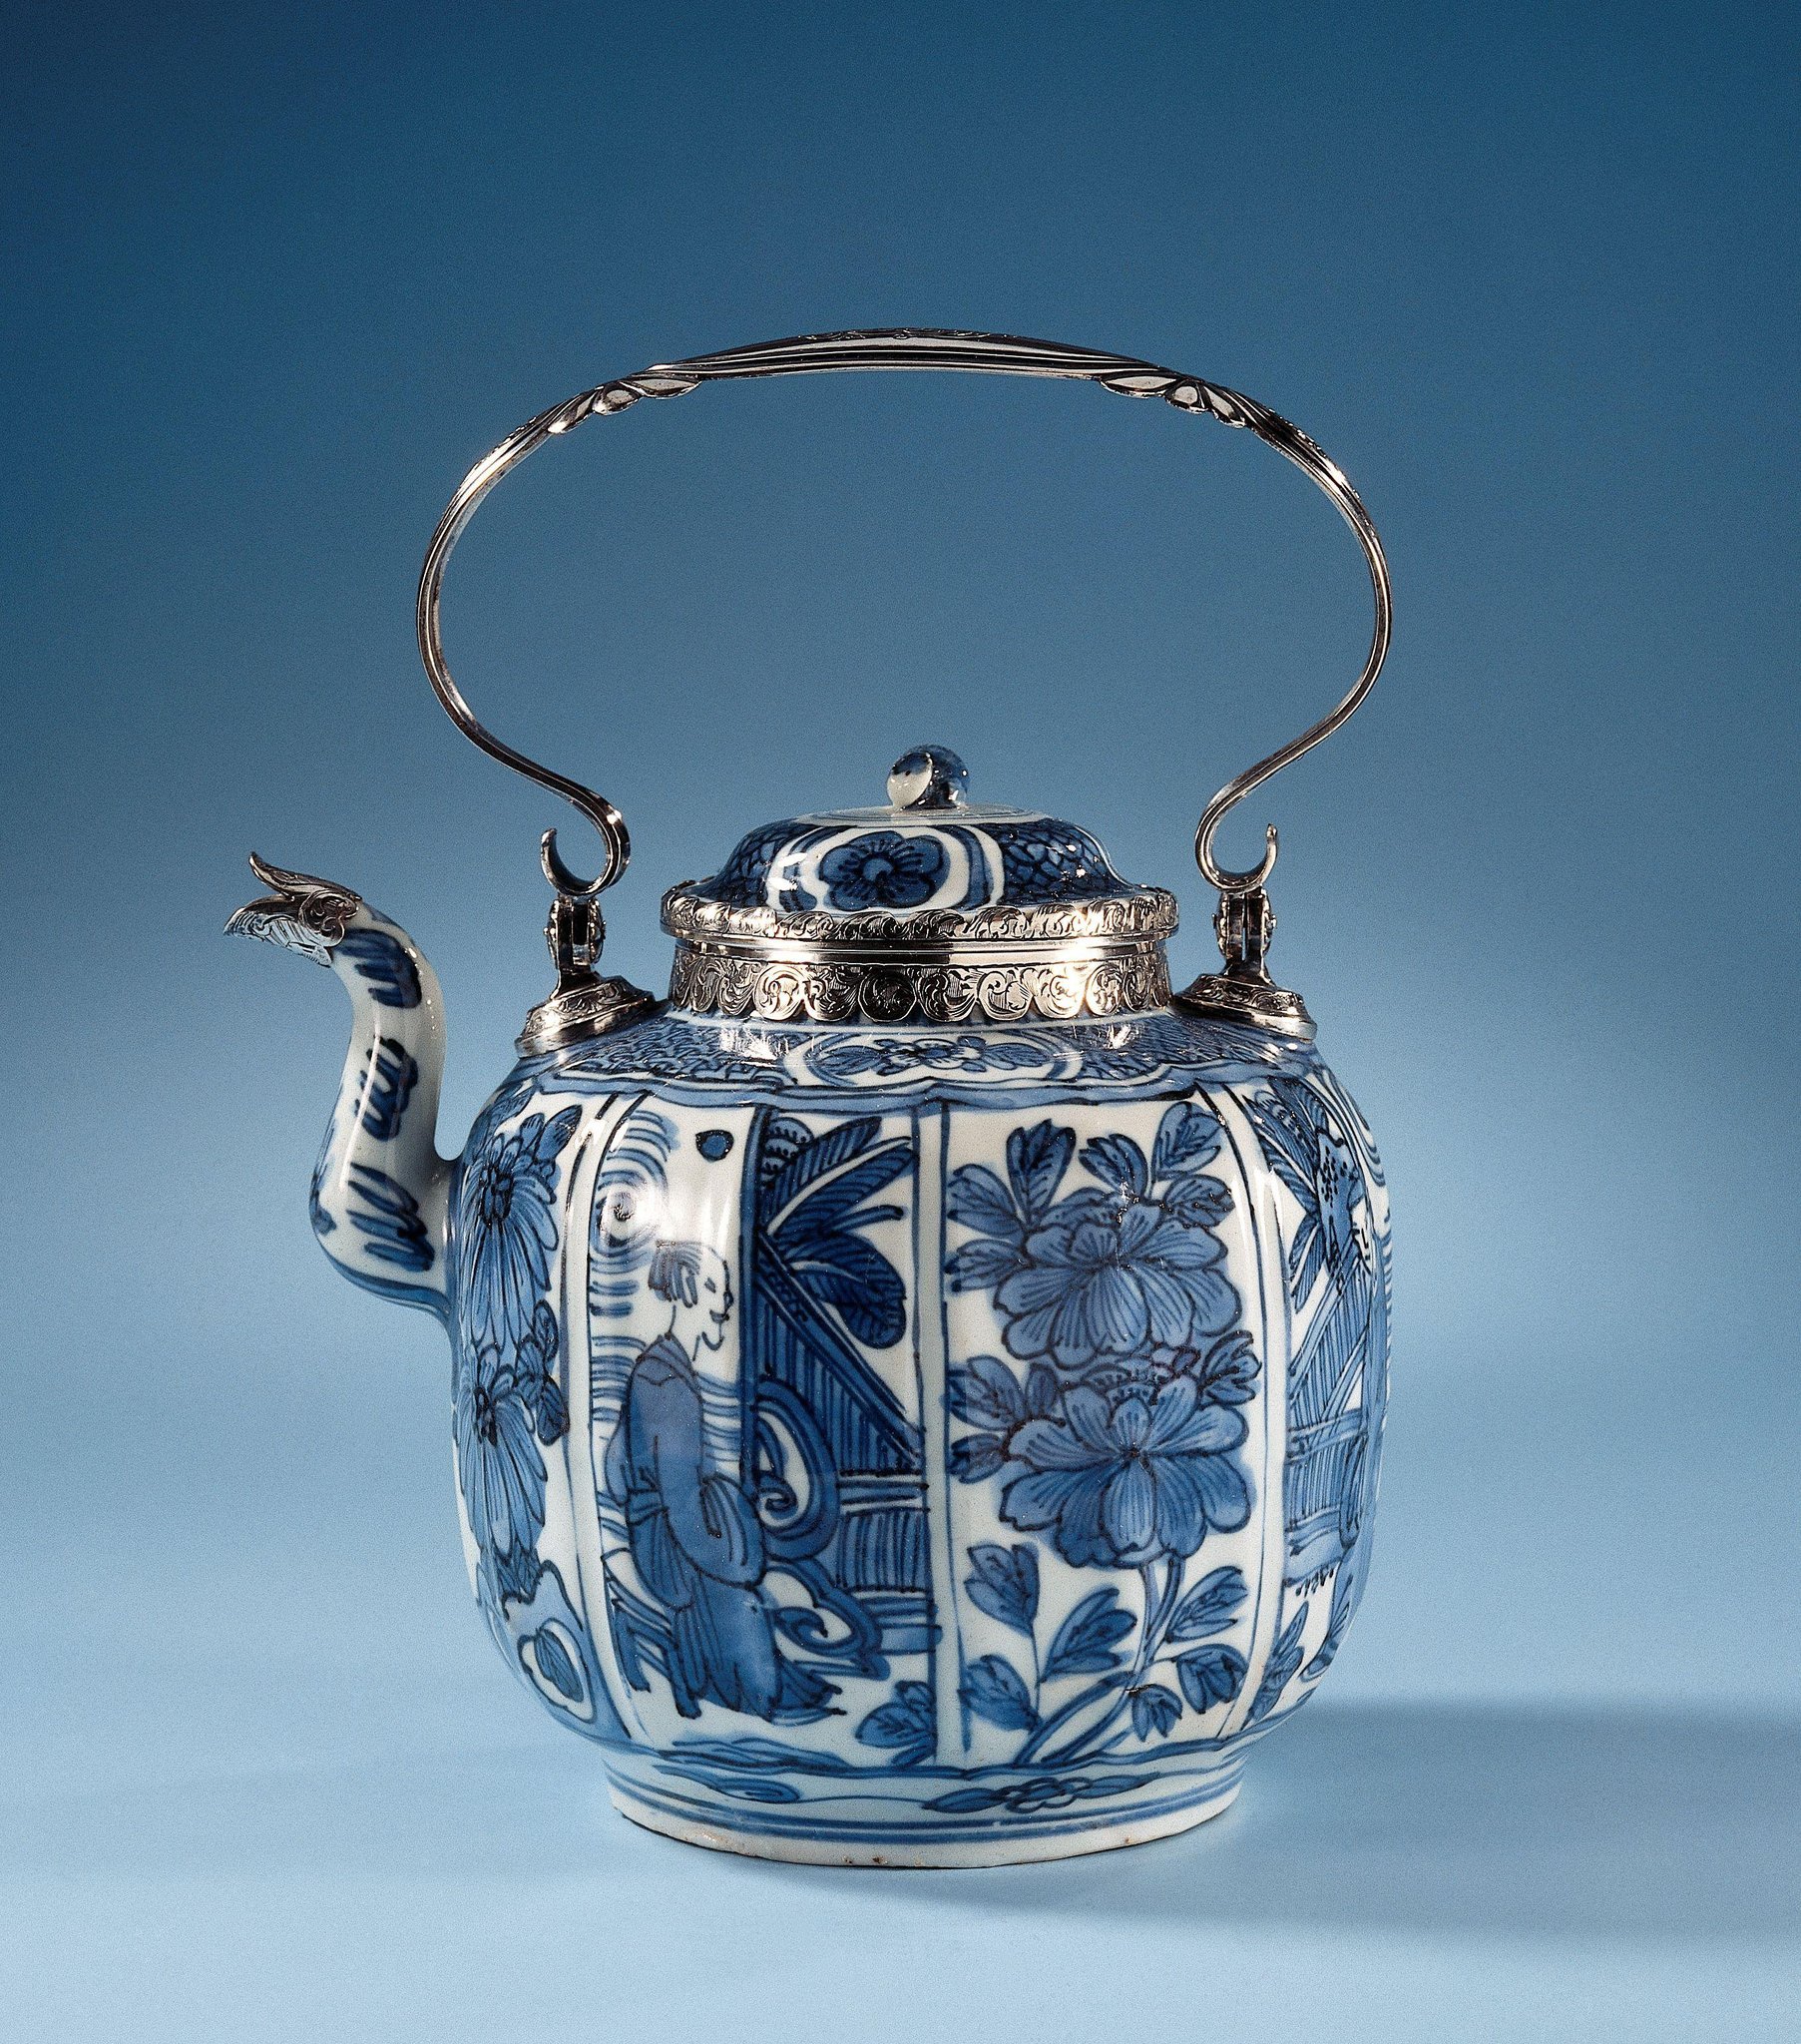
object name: teapot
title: Teapot with panel decoration with flowering plants, figures and silver mounts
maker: Anonymous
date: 1610-1630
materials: cobalt, glaze, paint, porcelain, silver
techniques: firing, turning, vitrification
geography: china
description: Theepot van porselein met een geribd, bolvormig lichaam en S-vormige tuit, beschilderd in onderglazuur blauw. De wand is verdeeld in vakken met afwisselend een bloeiende plant (chrysant, pioen) en een persoon zittend op een omheind terras; de schouder met een band servetwerk afgewisseld met een bloem in een cartouche. Voorzien van een 19e-eeuws zilveren montuur en handvat door Arnoldi & Wielick, Amsterdam 1850. Kraakporselein.